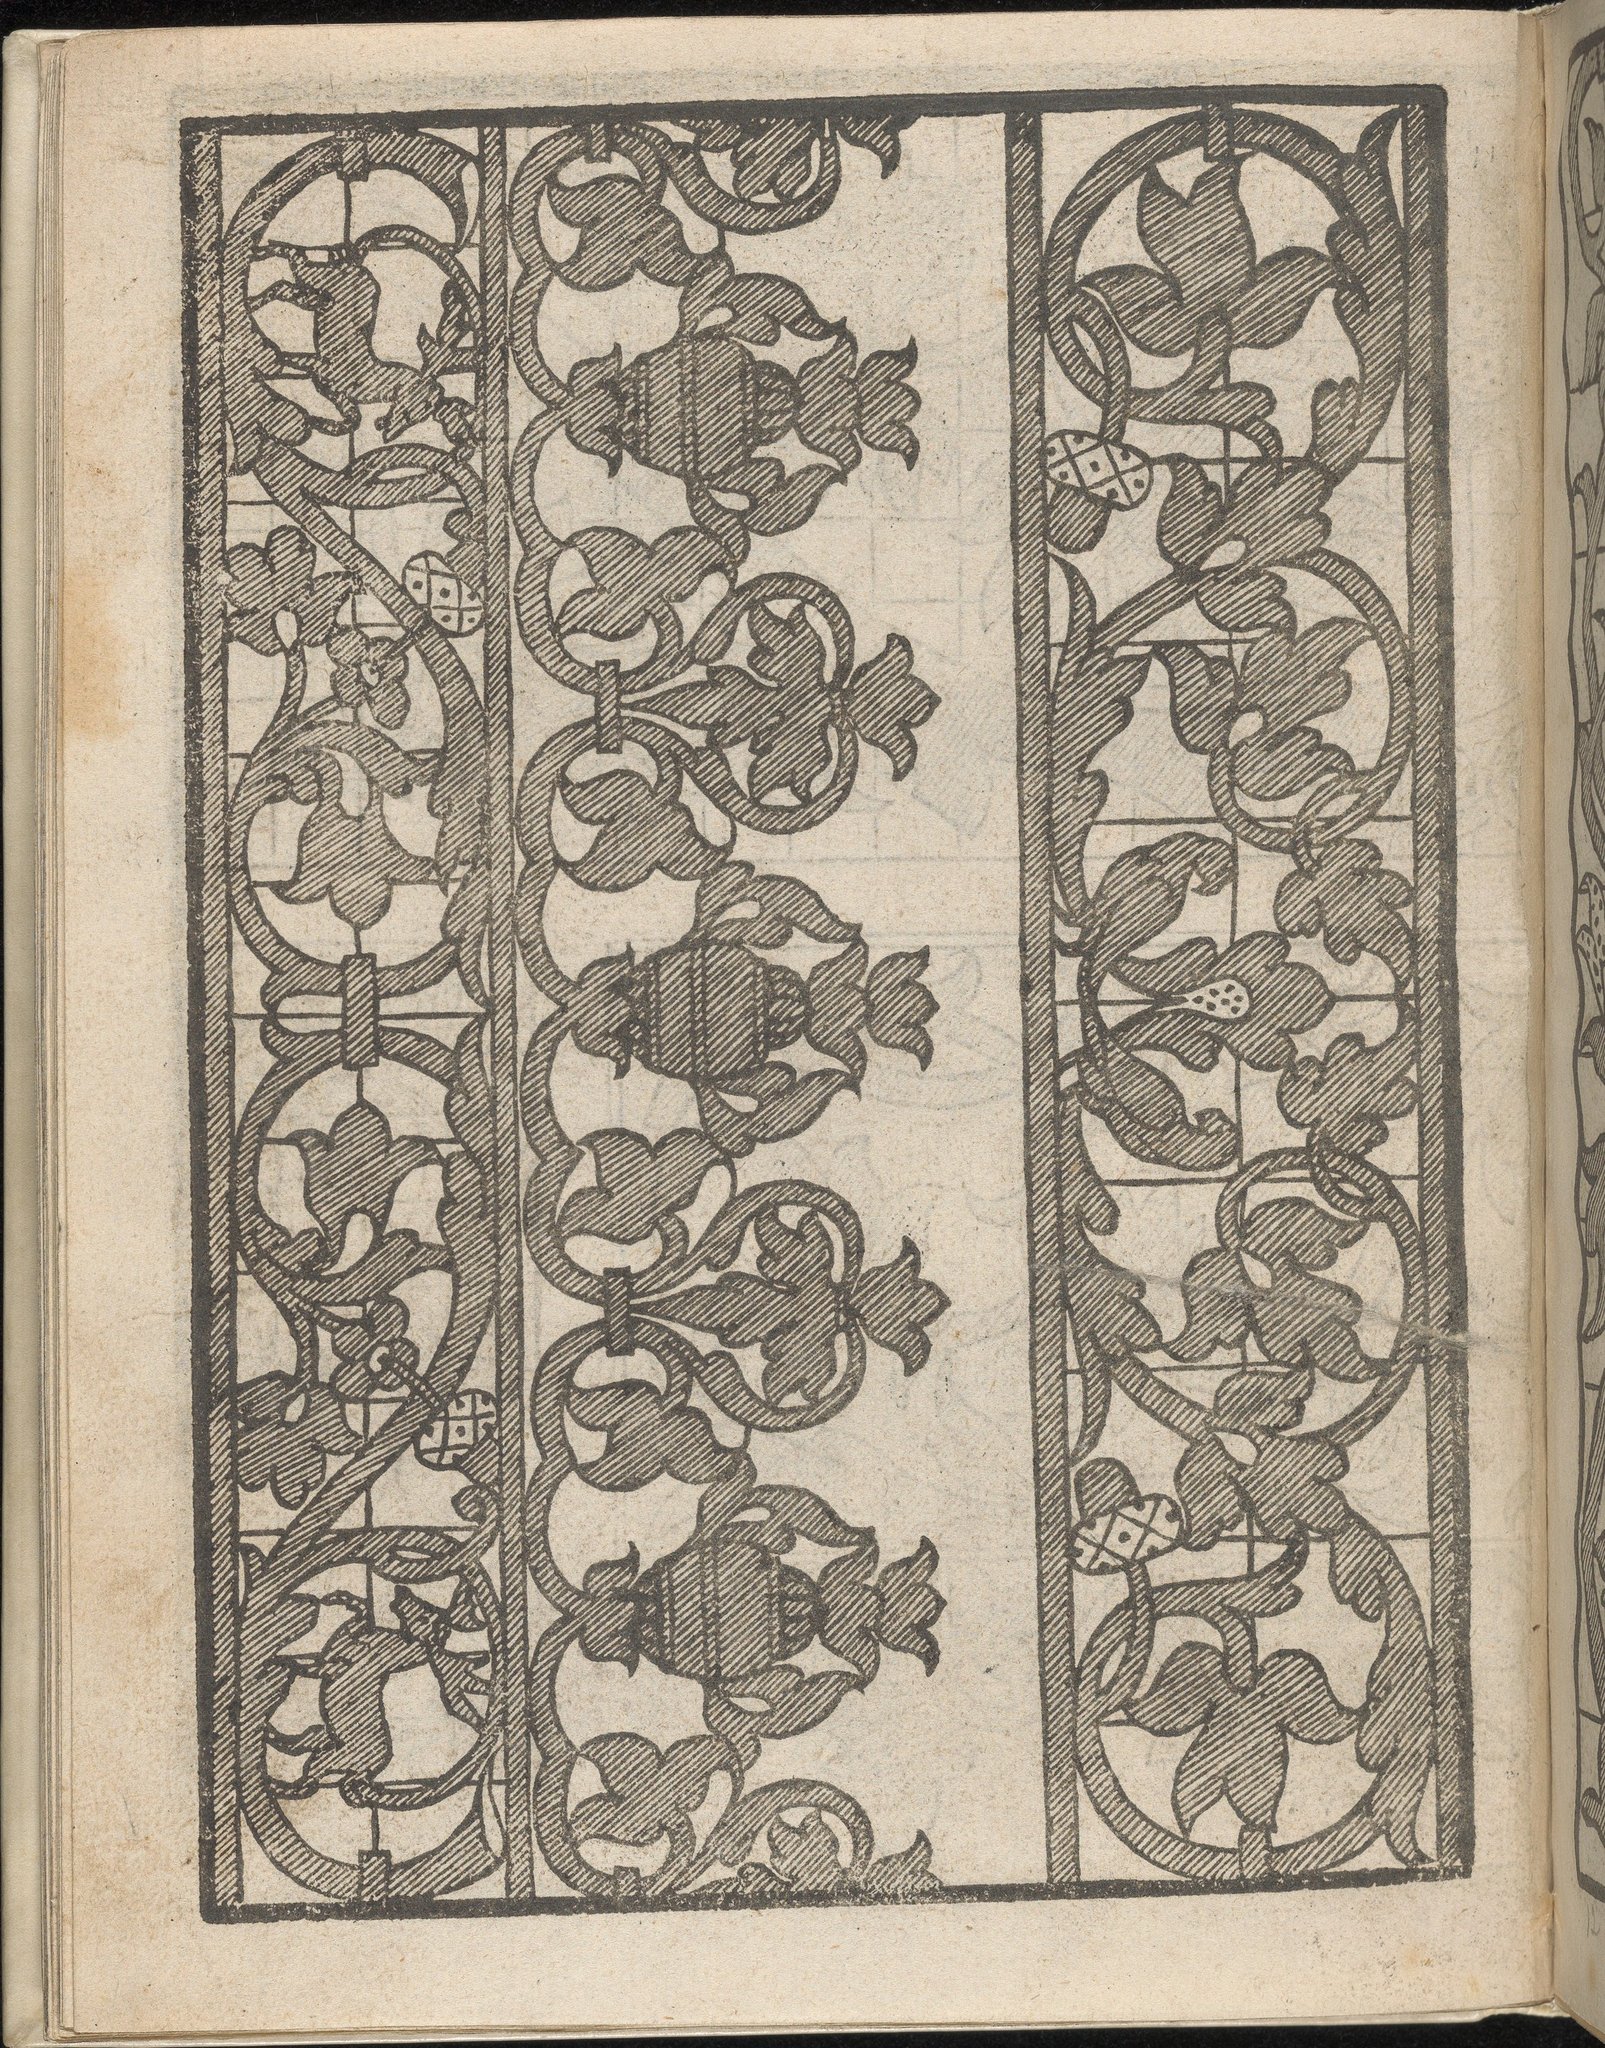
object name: book print ornament architecture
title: Lucidario di Recami, page 13 (verso)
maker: iseppo foresto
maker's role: designer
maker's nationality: italian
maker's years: 1520-1580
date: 1564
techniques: woodcut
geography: italy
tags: flowers,vases